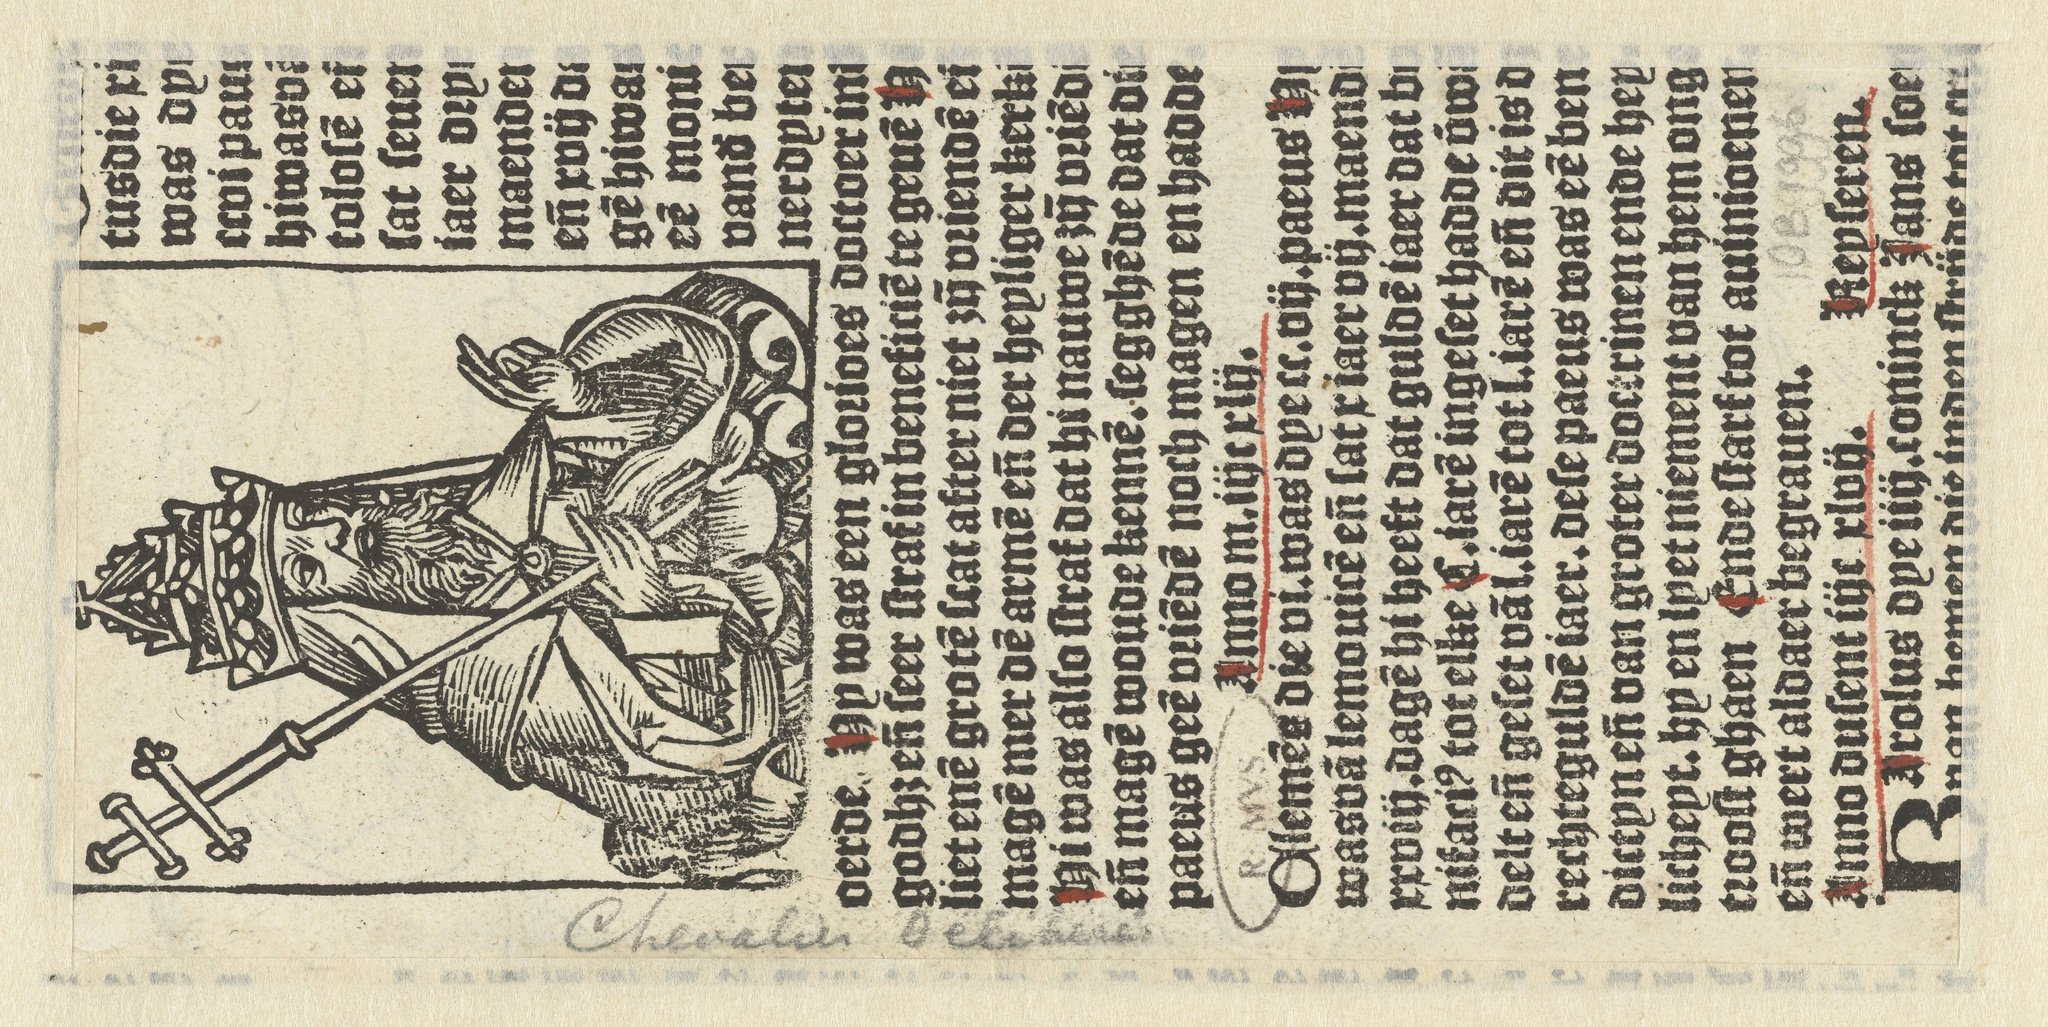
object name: print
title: Paus Benedictus XII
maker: Anonymous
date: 1517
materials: paper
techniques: woodcut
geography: low countries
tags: historical persons, (scenes from) specific works of literature (with author, title), pope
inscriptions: collector's mark: Lugt 2228a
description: Late afdruk van de versneden houtblokken van Le Chevalier déliberé van Olivier de la Marche (Gouda 1486). Eén blad van veertien uit Cronycke van Hollandt, uitgegeven door Jan Seversz, te Leiden in 1517 en 1530. Afbeelding is gelijk aan RP-P-OB-1995(V), maar in een andere tekst geplaatst.